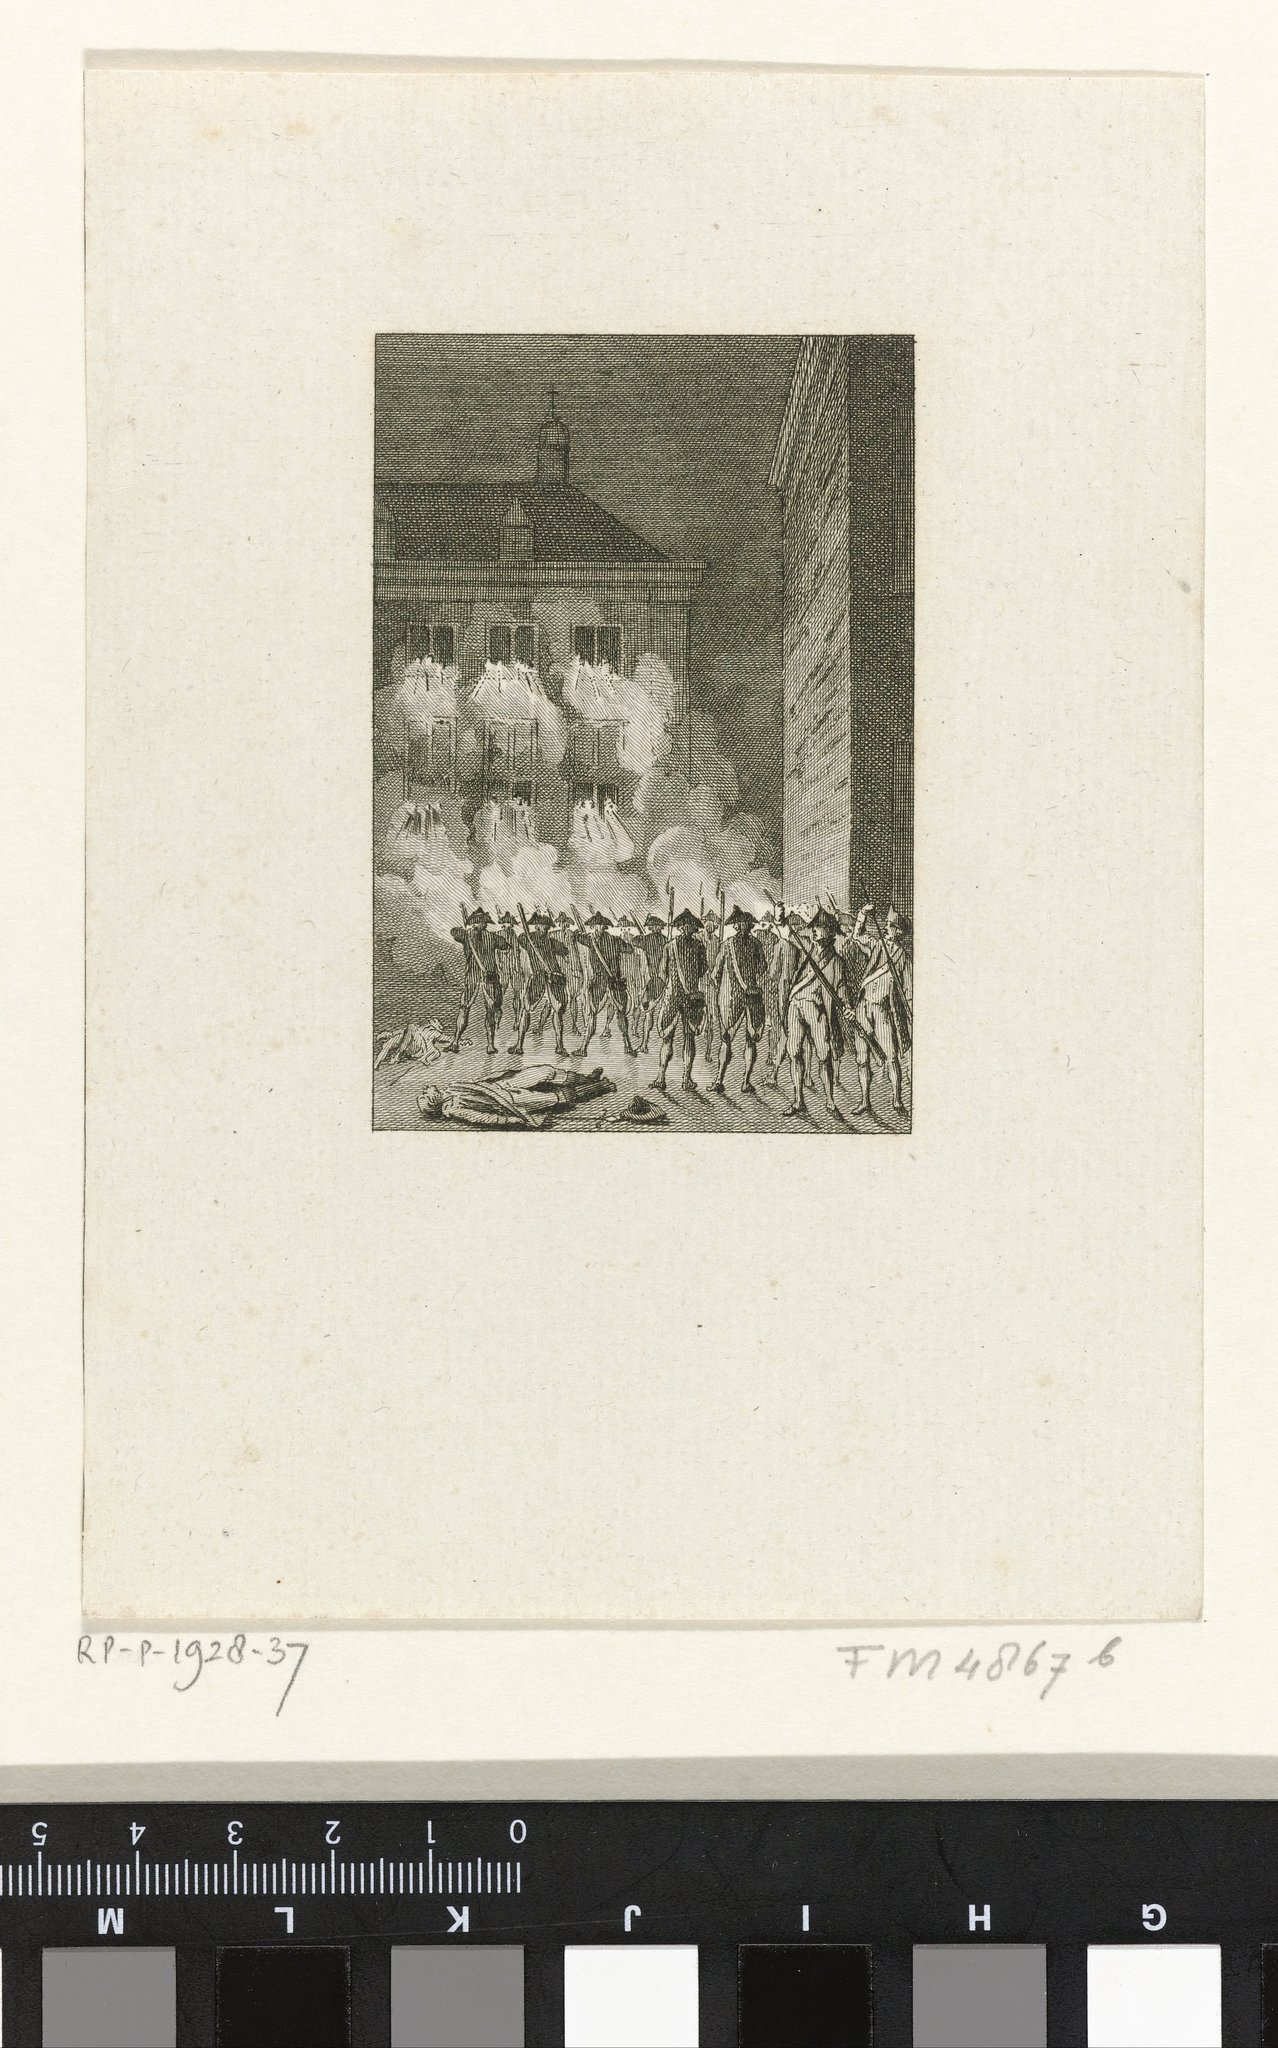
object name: print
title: Aanval op Soestdijk, 1787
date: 1787-1795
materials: paper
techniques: engraving, etching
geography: northern netherlands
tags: (military) attack (+ citizen soldiery, civil guard, citizen militia), patriots (1780-1795)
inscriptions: collector's mark: Lugt 2228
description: Het Paleis te Soestdijk aangevallen door patriotten uit Utrecht maar verdedigd door een detachement Duitse troepen, 27 juli 1787. Op de voorgrond het lichaam van de doodgeschoten soldaat Christoffel Pullman.